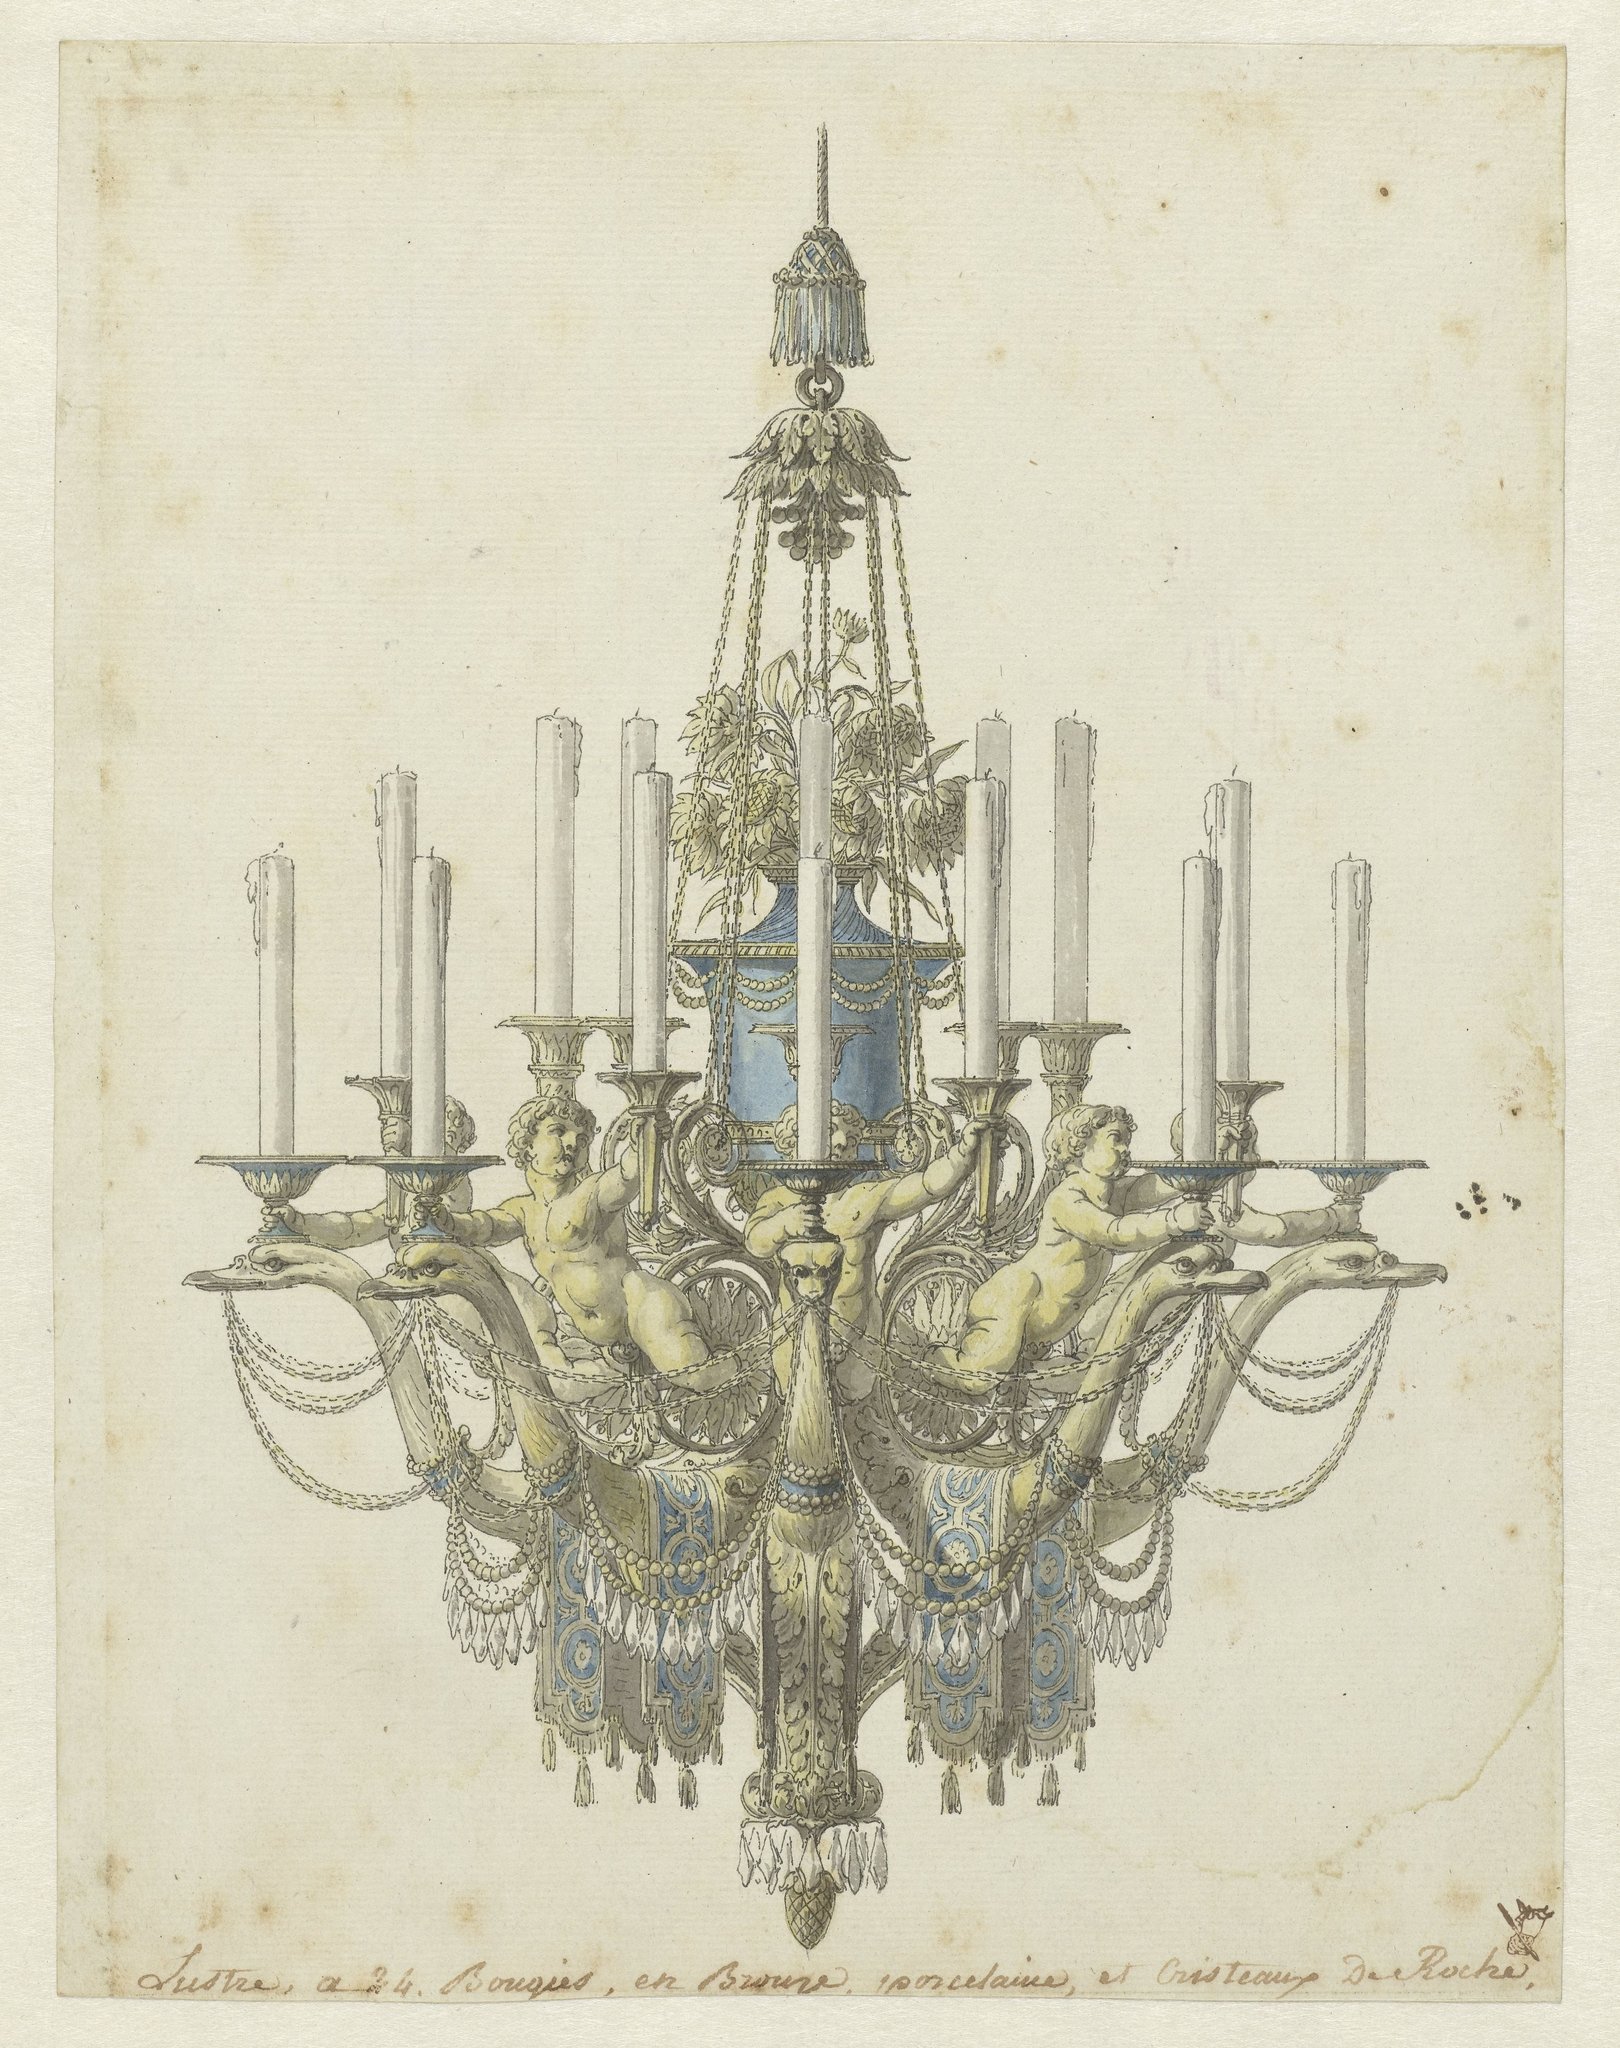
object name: design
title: Design for a Chandelier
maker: jean démosthène dugourc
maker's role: draughtsman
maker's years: 1749-1825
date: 1784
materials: ink, paper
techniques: brush, pen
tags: chandelier, candelabrum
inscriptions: inscription: ‘Lustre, a 24. Bougies, en Bronze, porcelaine, et Cristeaux De Roche.’, collector's mark, recto, lower right: Lugt 3893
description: Dugurc designed this chandelier for Grand Duke Paul of Russia, later Tsar Paul i. The blue parts were intended to be executed in Sèvres porcelain, the yellow ones in gilt bronze, and the drops were to be of rock-crystal. This grandiose object, which was to have a height of approximately 150 cm, was never executed.